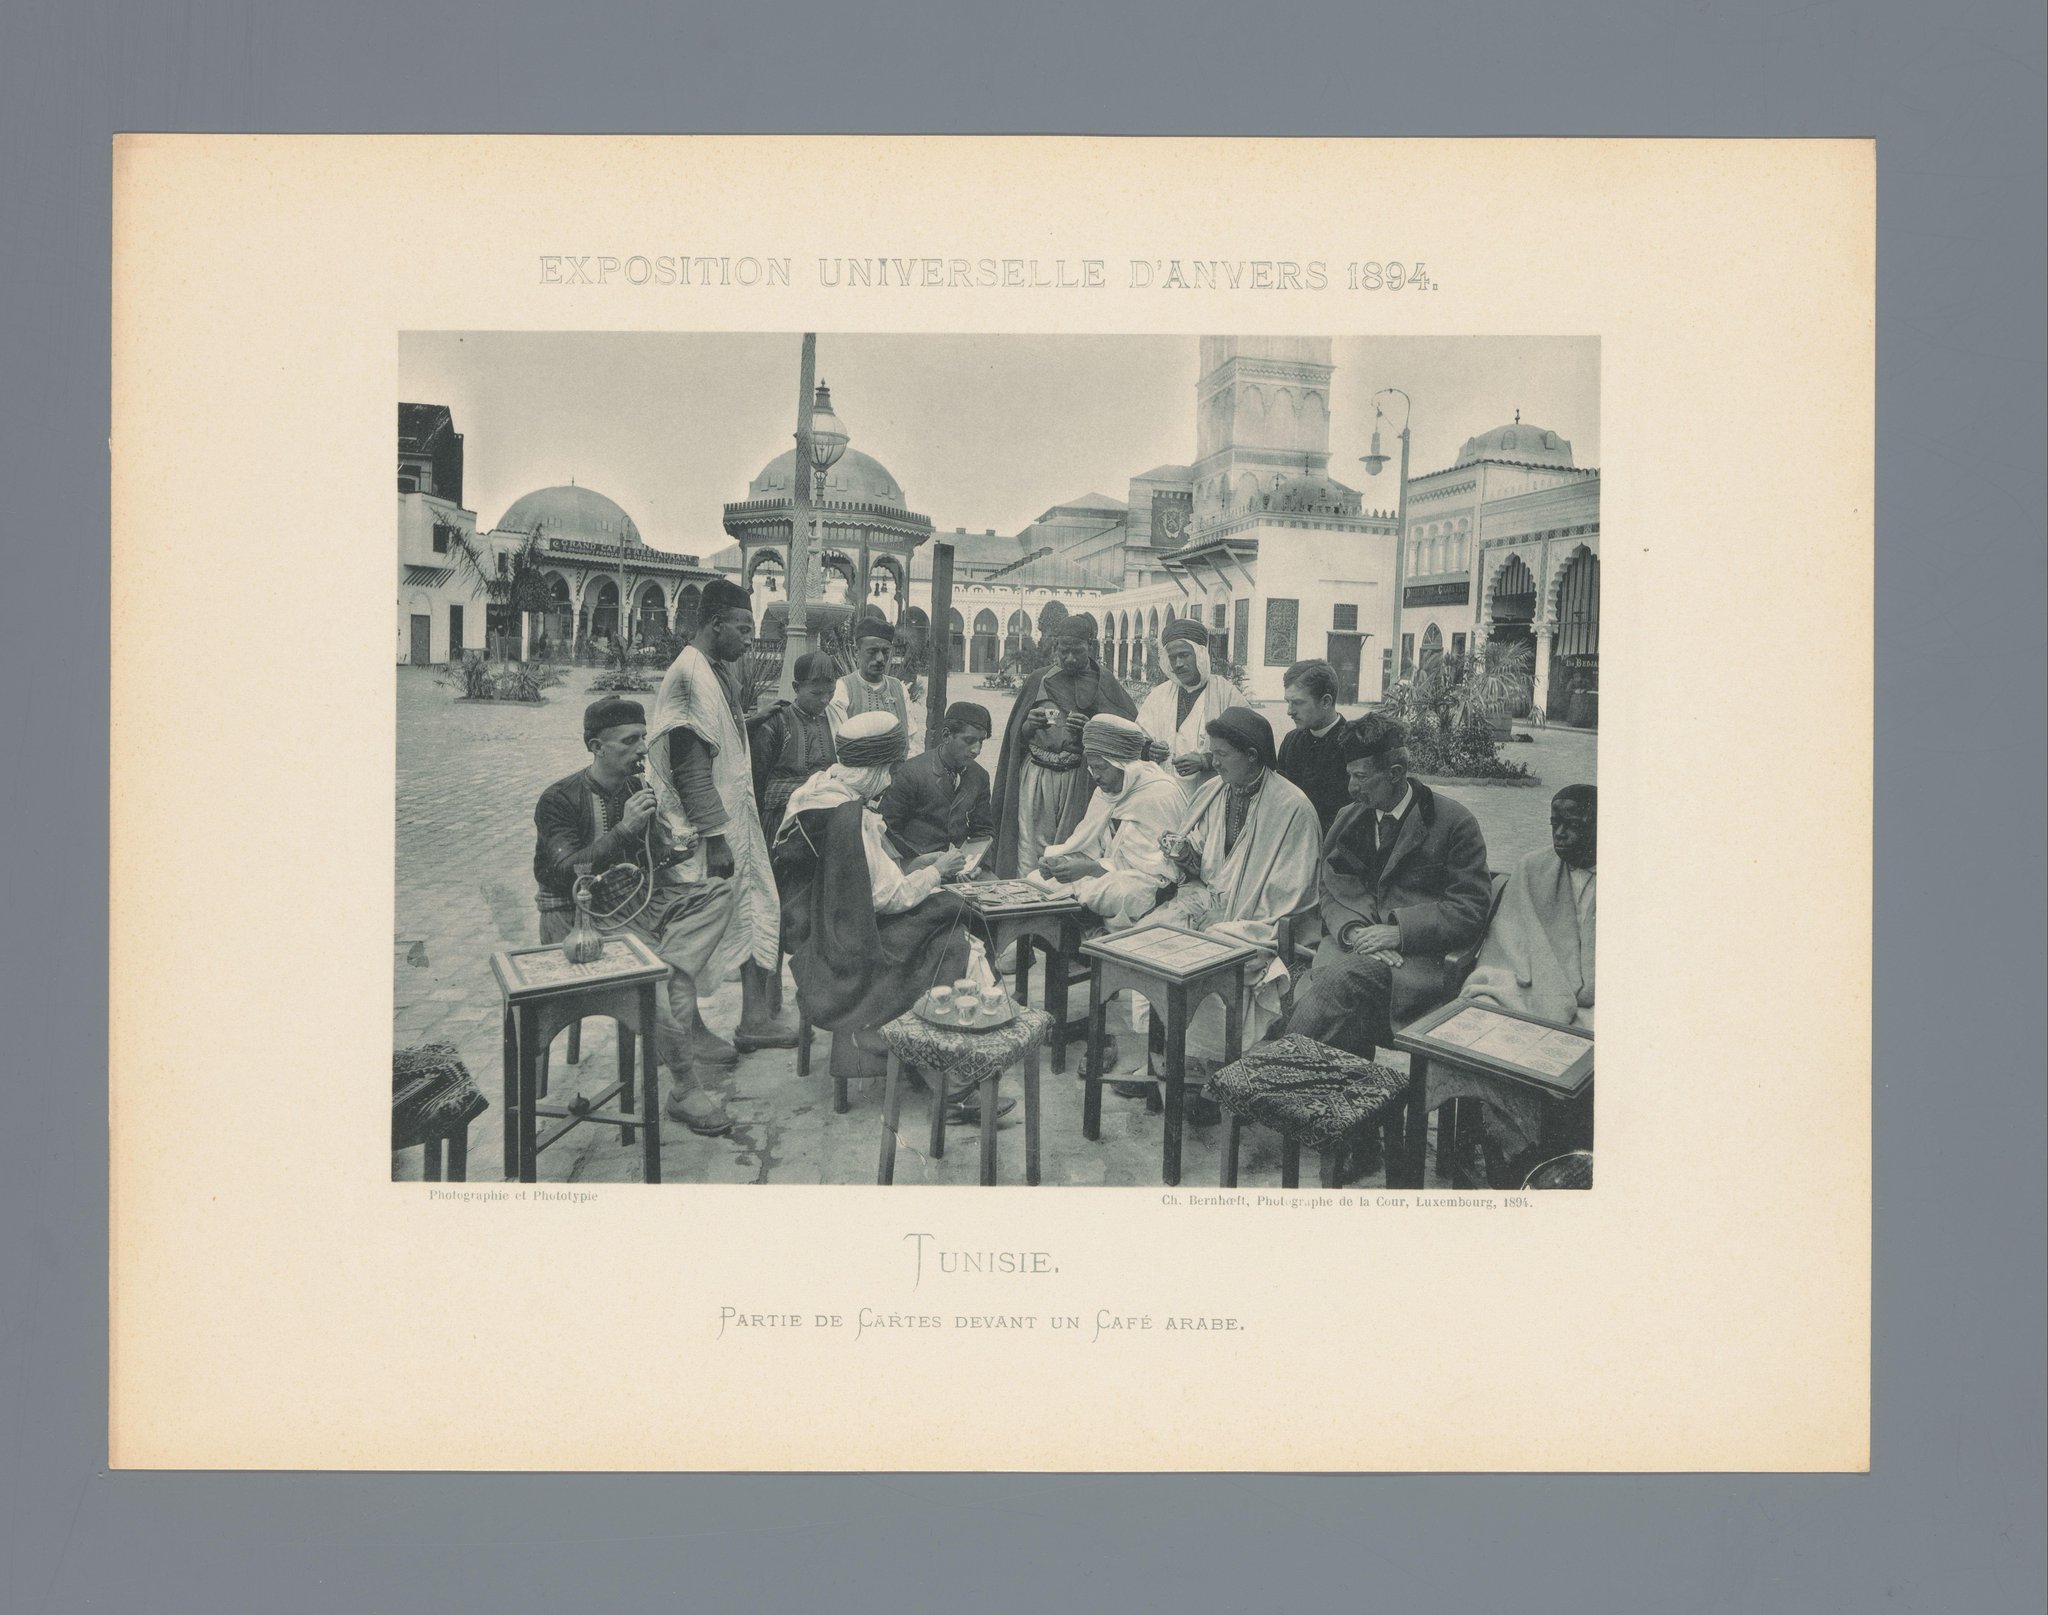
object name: photomechanical print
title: Partie de cartes devant un cafe arabe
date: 1894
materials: paper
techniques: photograph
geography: antwerp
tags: water-pipe, hookah, narghile, world fair, world exhibition, adult man, card games, asiatic races and peoples (with name), antwerp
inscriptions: inscription: ‘Exposition Universelle D'Anvers 1894’